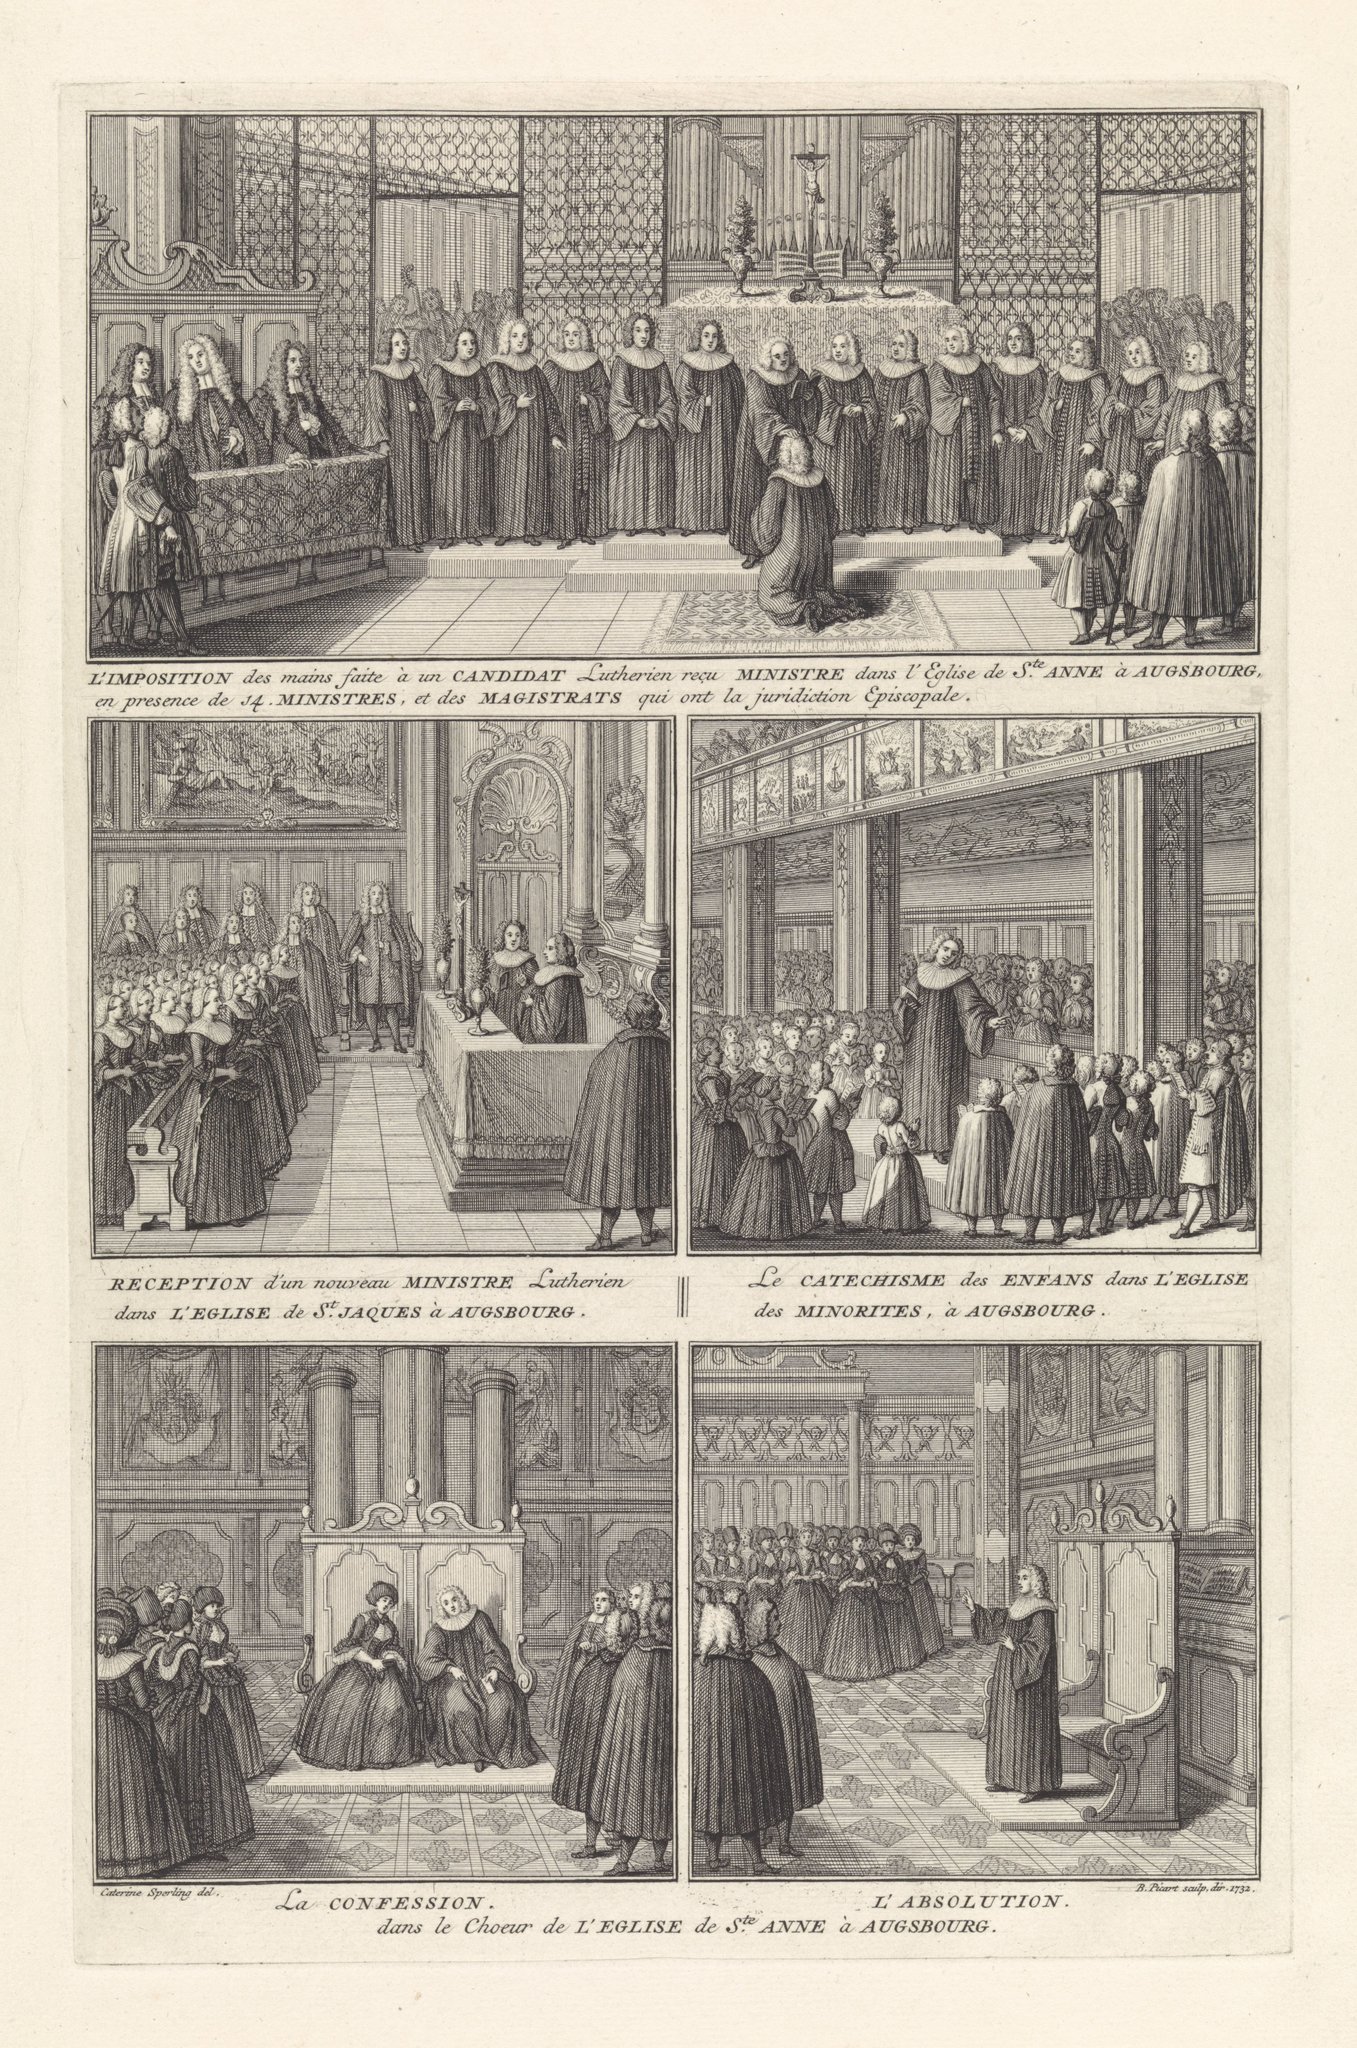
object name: book illustration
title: Installatie van nieuwe predikanten, catechisatie en biecht bij de lutheranen in Augsburg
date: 1732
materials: paper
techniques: engraving, etching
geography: amsterdam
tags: catechism, organizational aspects ~ protestant churches, inauguration, consecration of person(s) ~ church, absolution, forgiveness of sins ~ part of the confession, confession; 'confessione sacramentale' (ripa) ~ the third of the seven sacraments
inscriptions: collector's mark: Lugt 2228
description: Blad met vijf voorstellingen van gebruiken bij de lutheranen van Augsburg. Boven: In de St. Anna kerk van Augsburg wordt een nieuwe predikant gezegend door hem de handen op te leggen. Midden links: Een nieuwe predikant wordt geïnstalleerd in de Kerk van de H. Jacobus van Augsburg. Midden rechts: Kinderen krijgen catechese van een predikant in de kerk van de Minorieten te Augsburg. Linksonder: Een predikant neemt de biecht af in de St. Anna kerk van Augsburg. Rechtsonder: Een predikant spreekt de absolutie uit over de kerkgangers in de St Anna kerk van Augsburg.